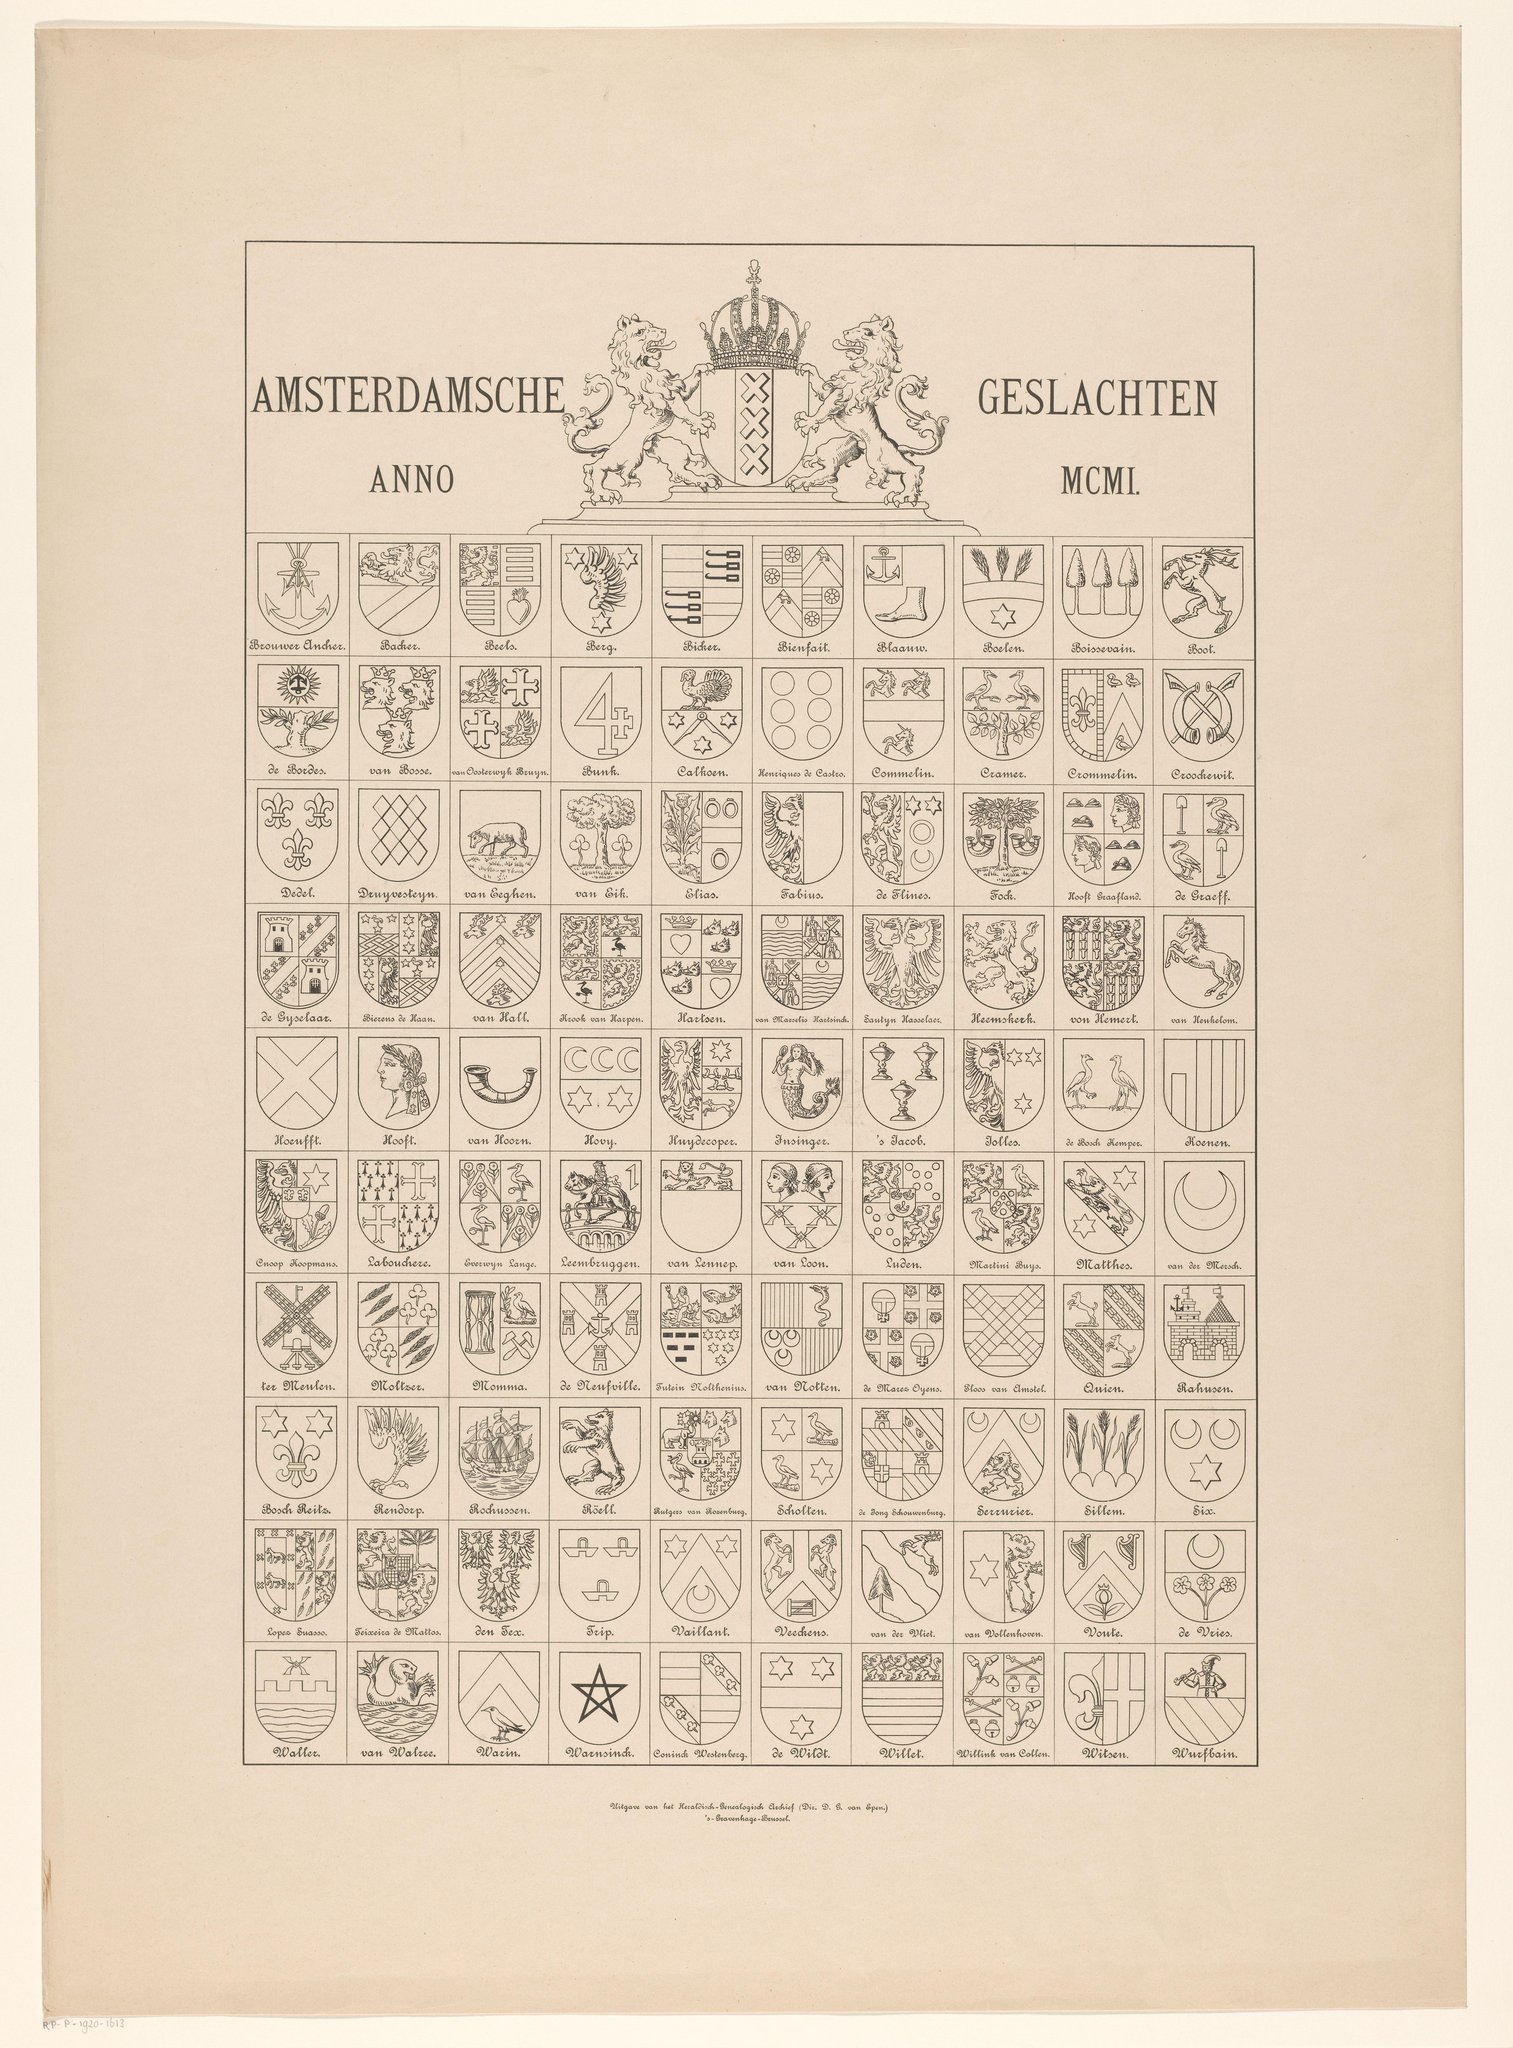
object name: print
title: Honderd familiewapens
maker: johannes evert van leeuwen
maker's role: painter, print maker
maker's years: 1855-1931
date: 1901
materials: paper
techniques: lithograph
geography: the hague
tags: armorial bearing, heraldry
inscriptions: collector's mark: Lugt 2233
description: Wapenbord met het wapen van Amsterdam en honderd familiewapens.